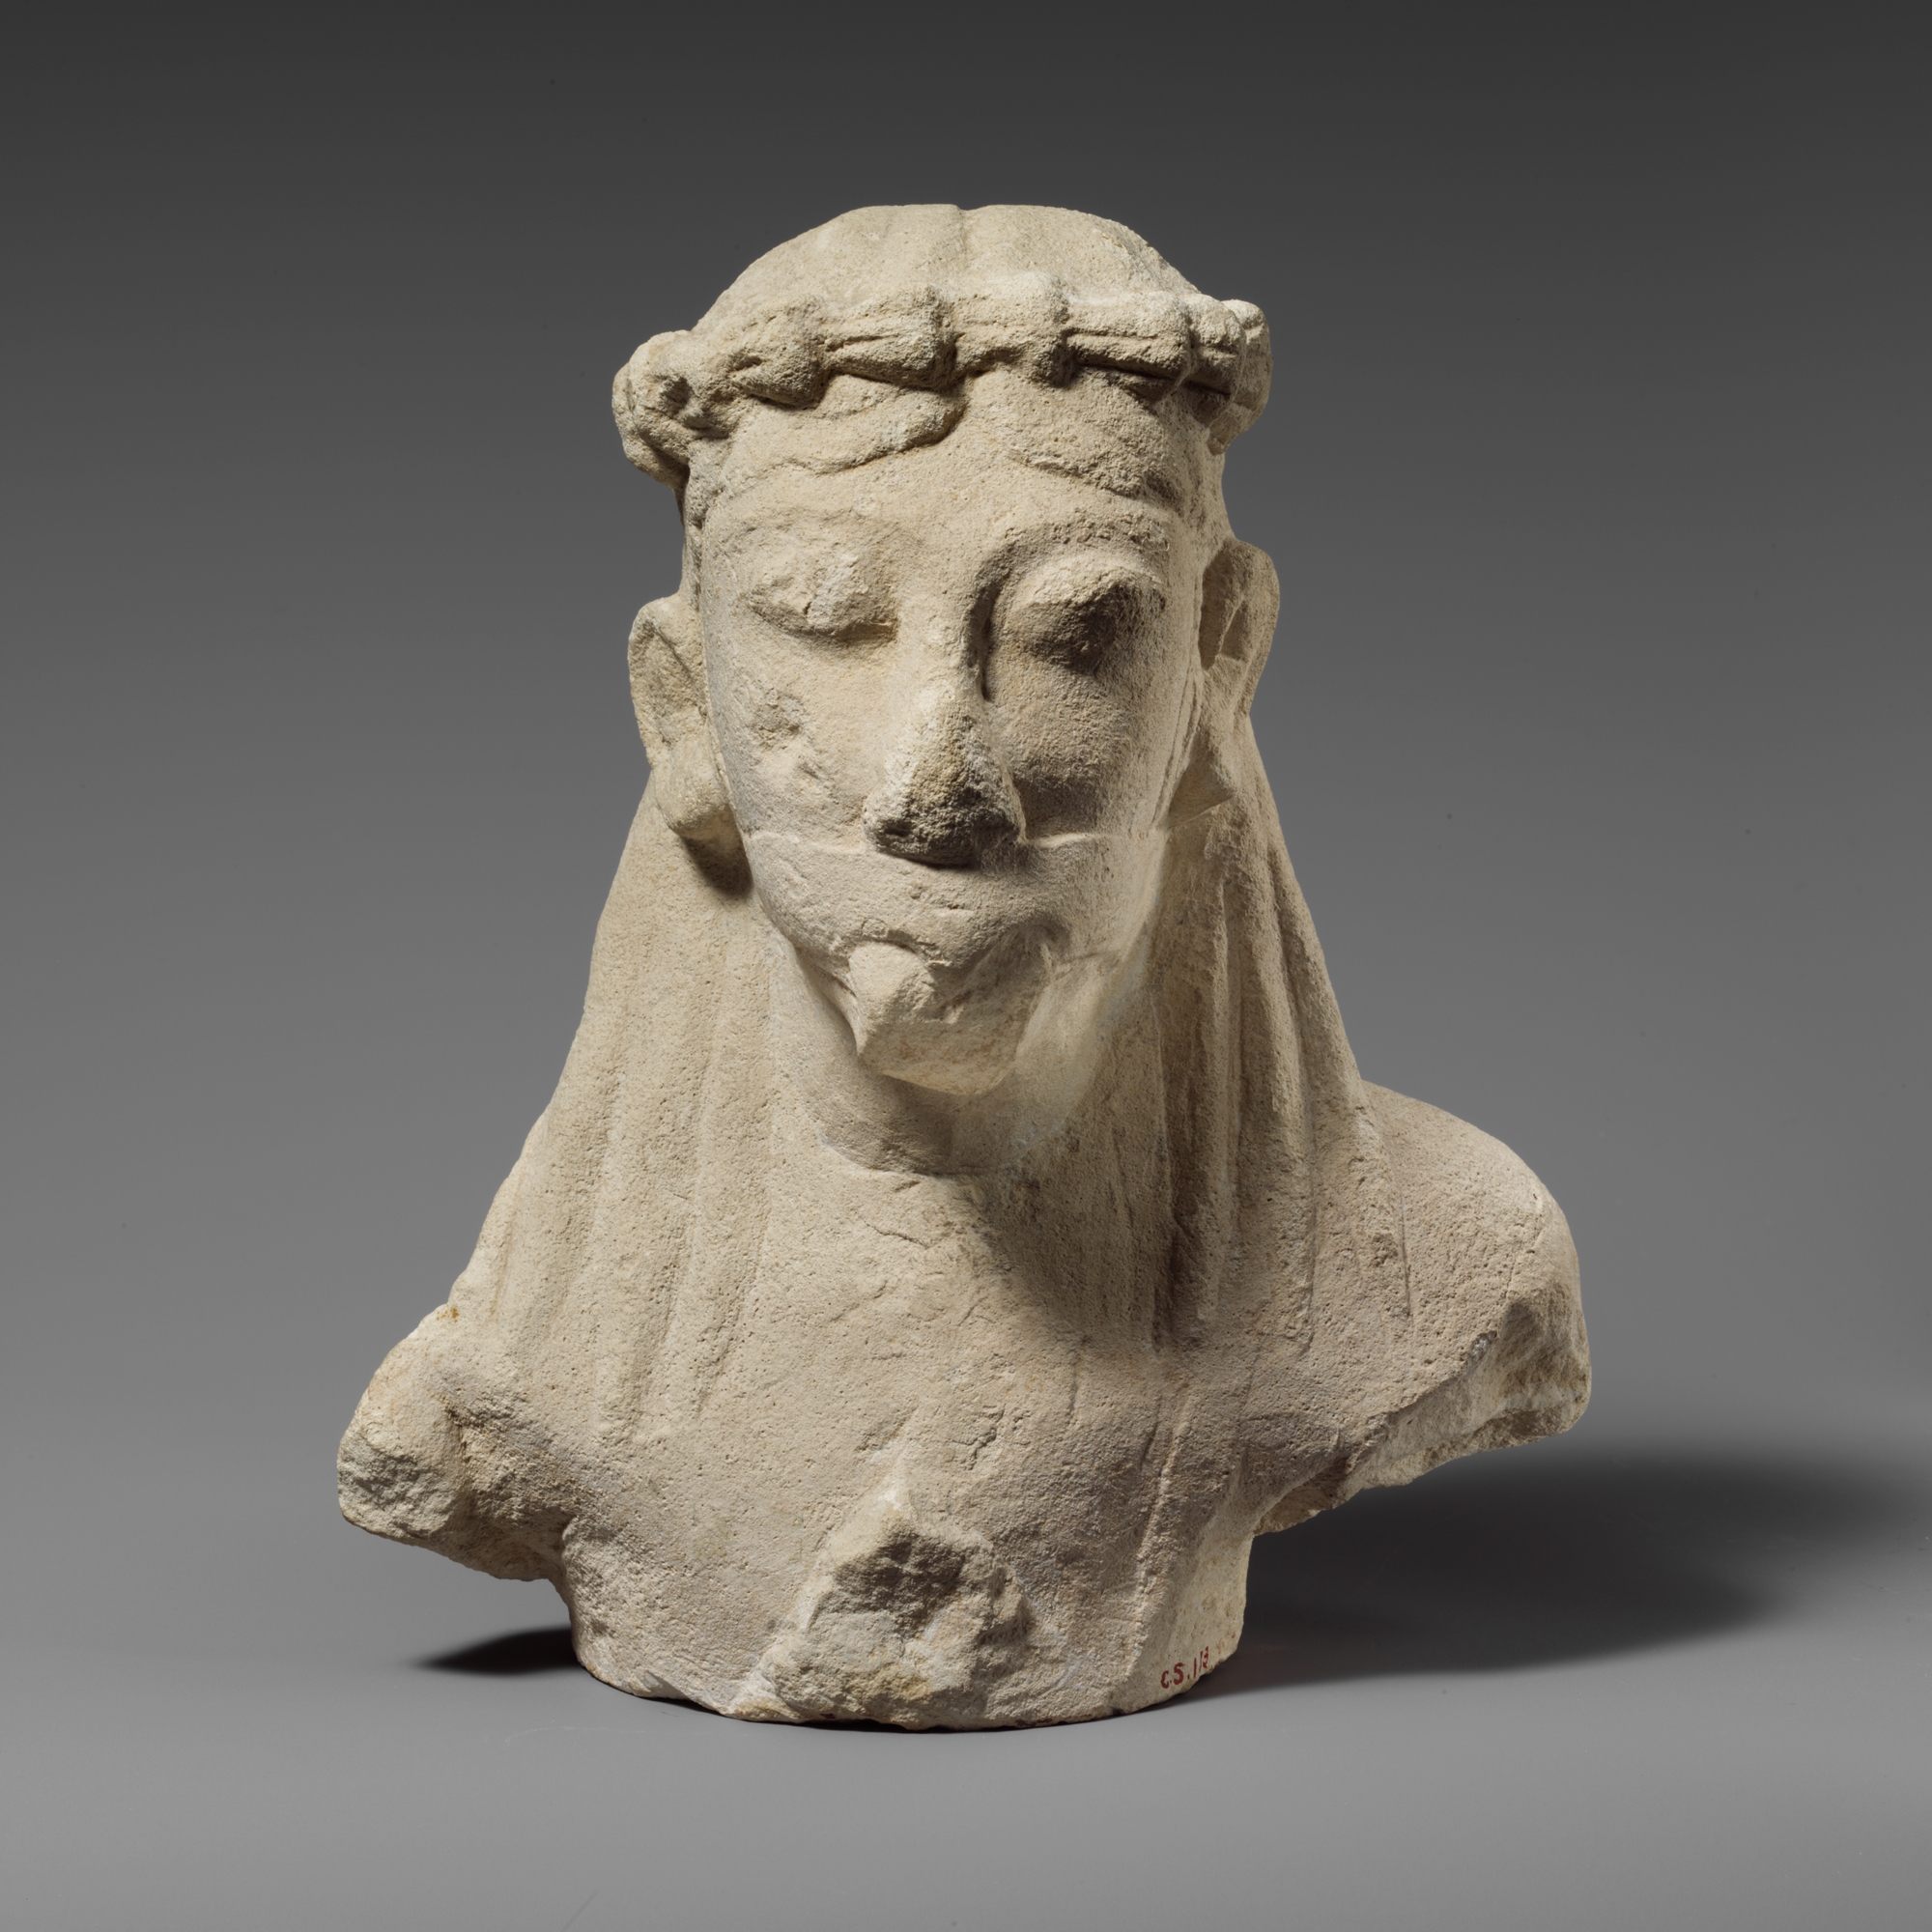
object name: statue of a flute player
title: Upper part of a limestone statuette of a male aulos player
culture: cypriot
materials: limestone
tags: men,musicians